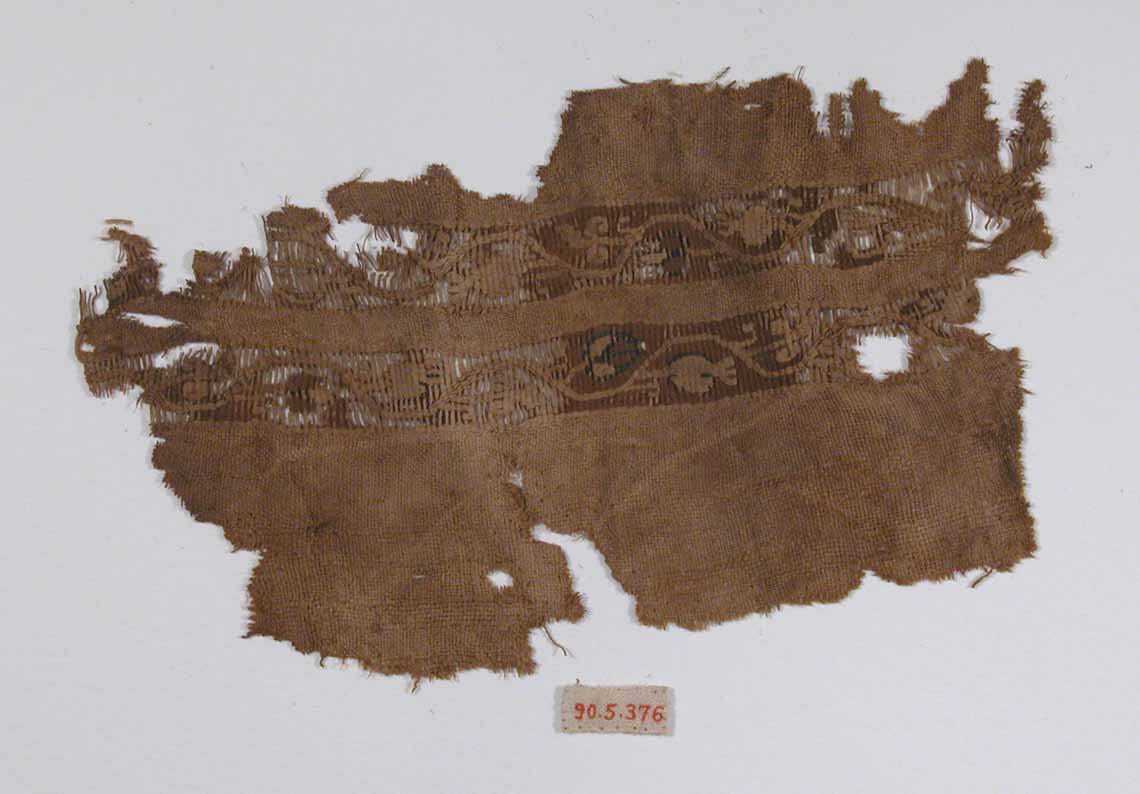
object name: textile fragment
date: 201-400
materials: linen, wool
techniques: weave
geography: egypt